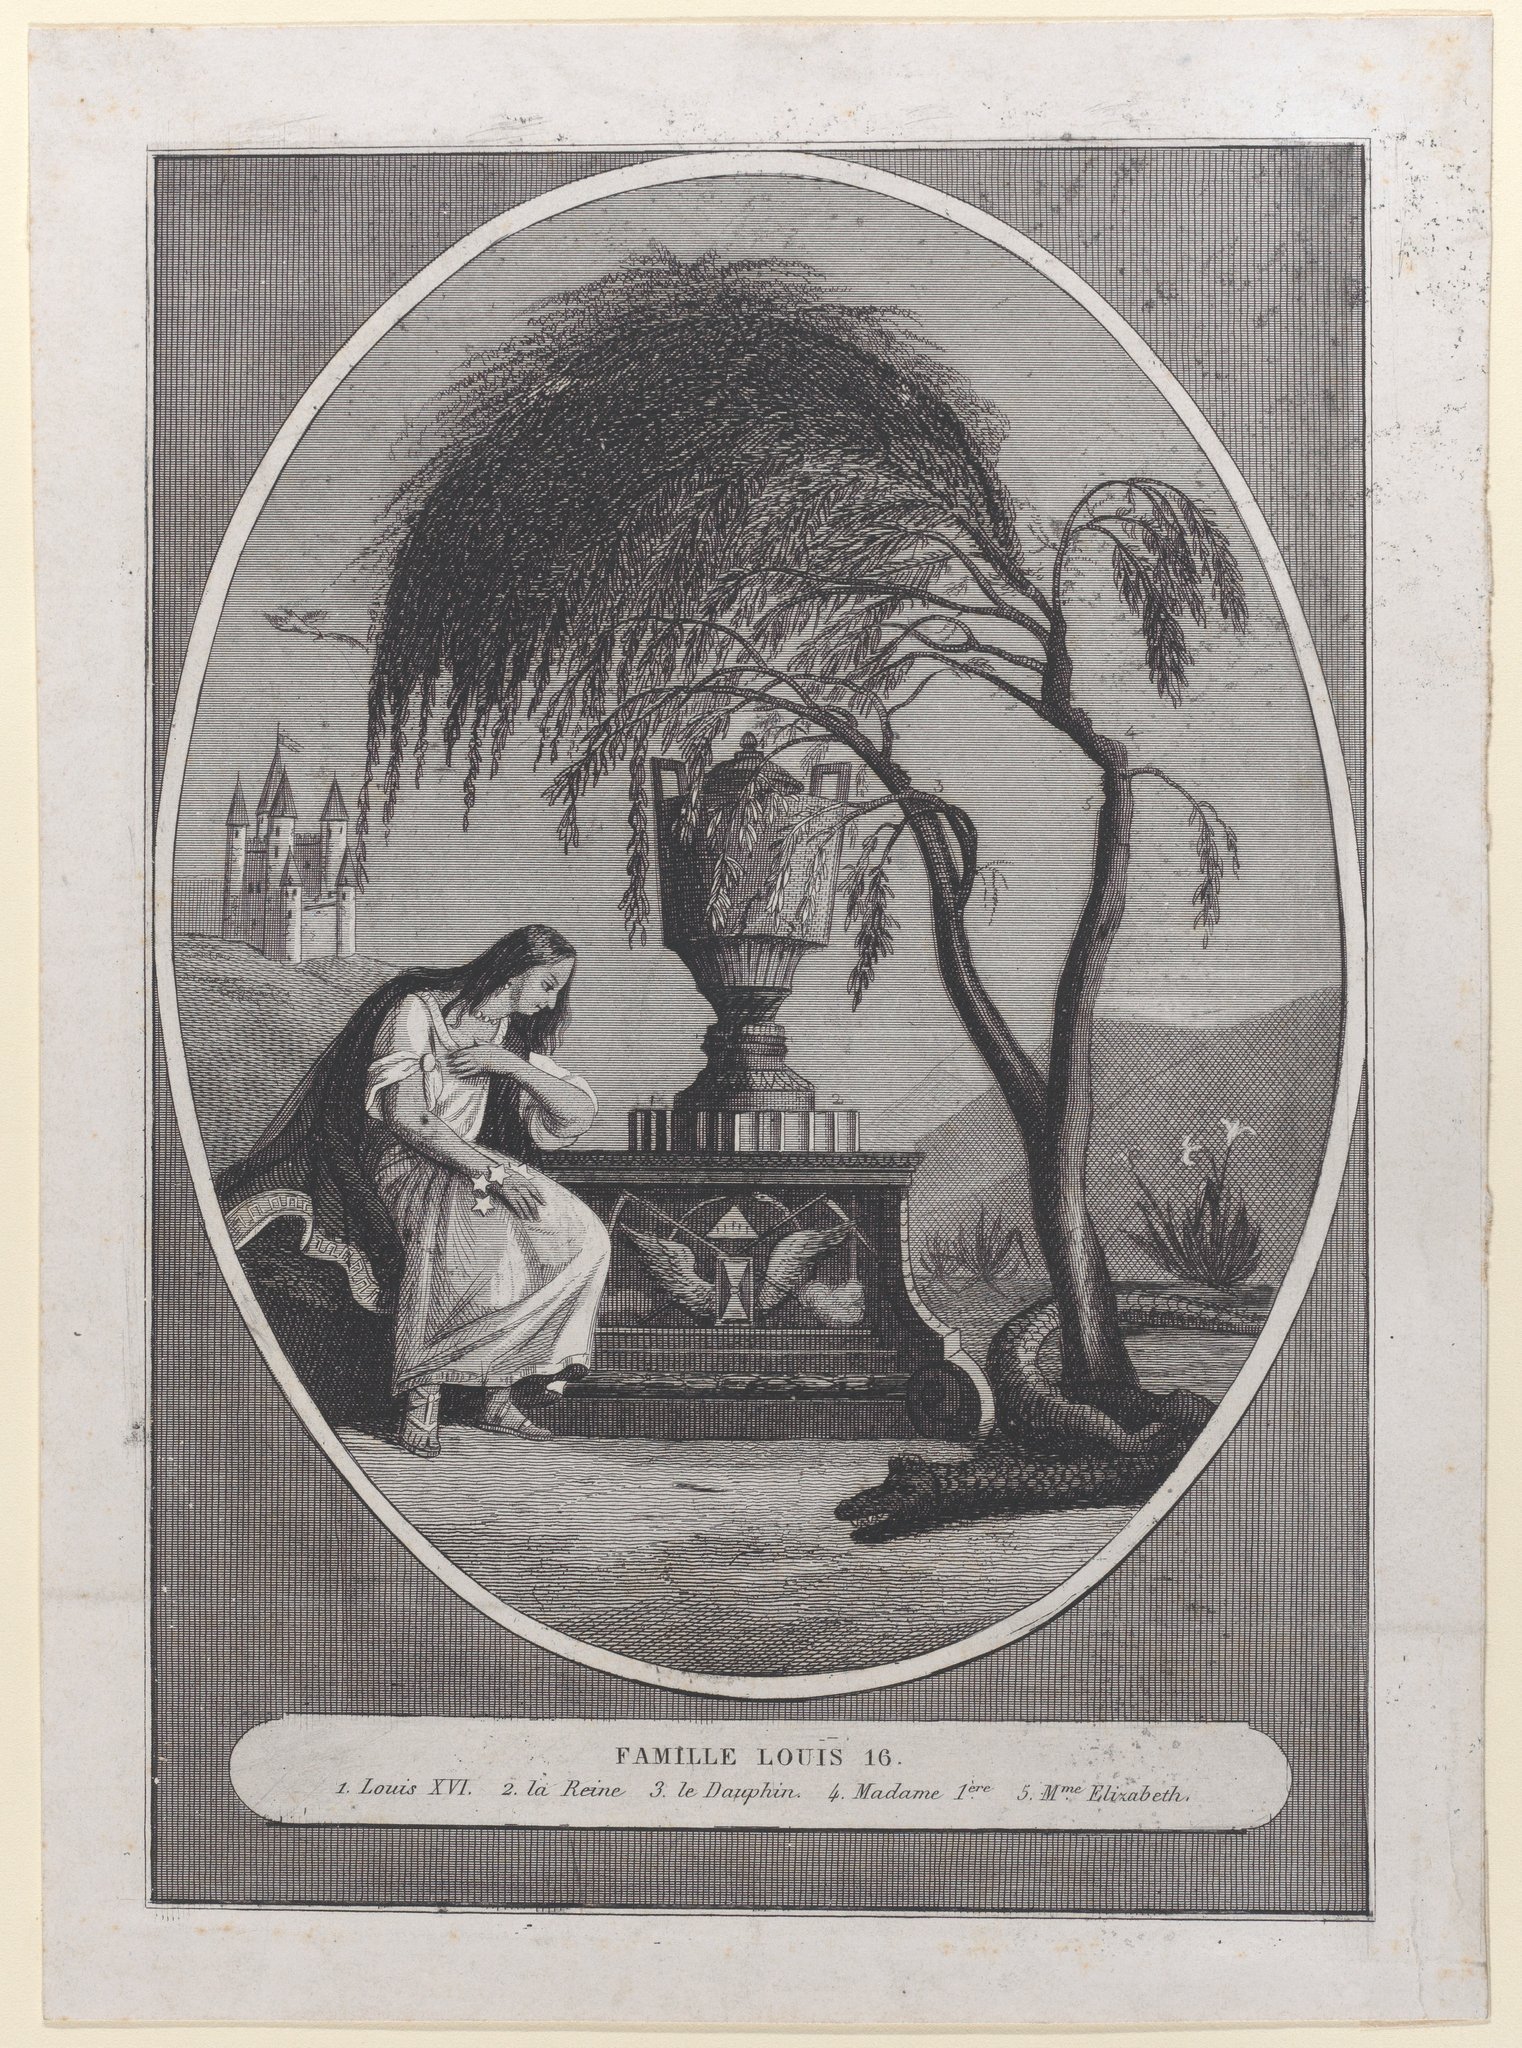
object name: print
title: Tomb of Louis XVI and his family, with hidden silhouettes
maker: Anonymous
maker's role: artist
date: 1793-1800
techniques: engraving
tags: tombs,louis xvi,marie antoinette